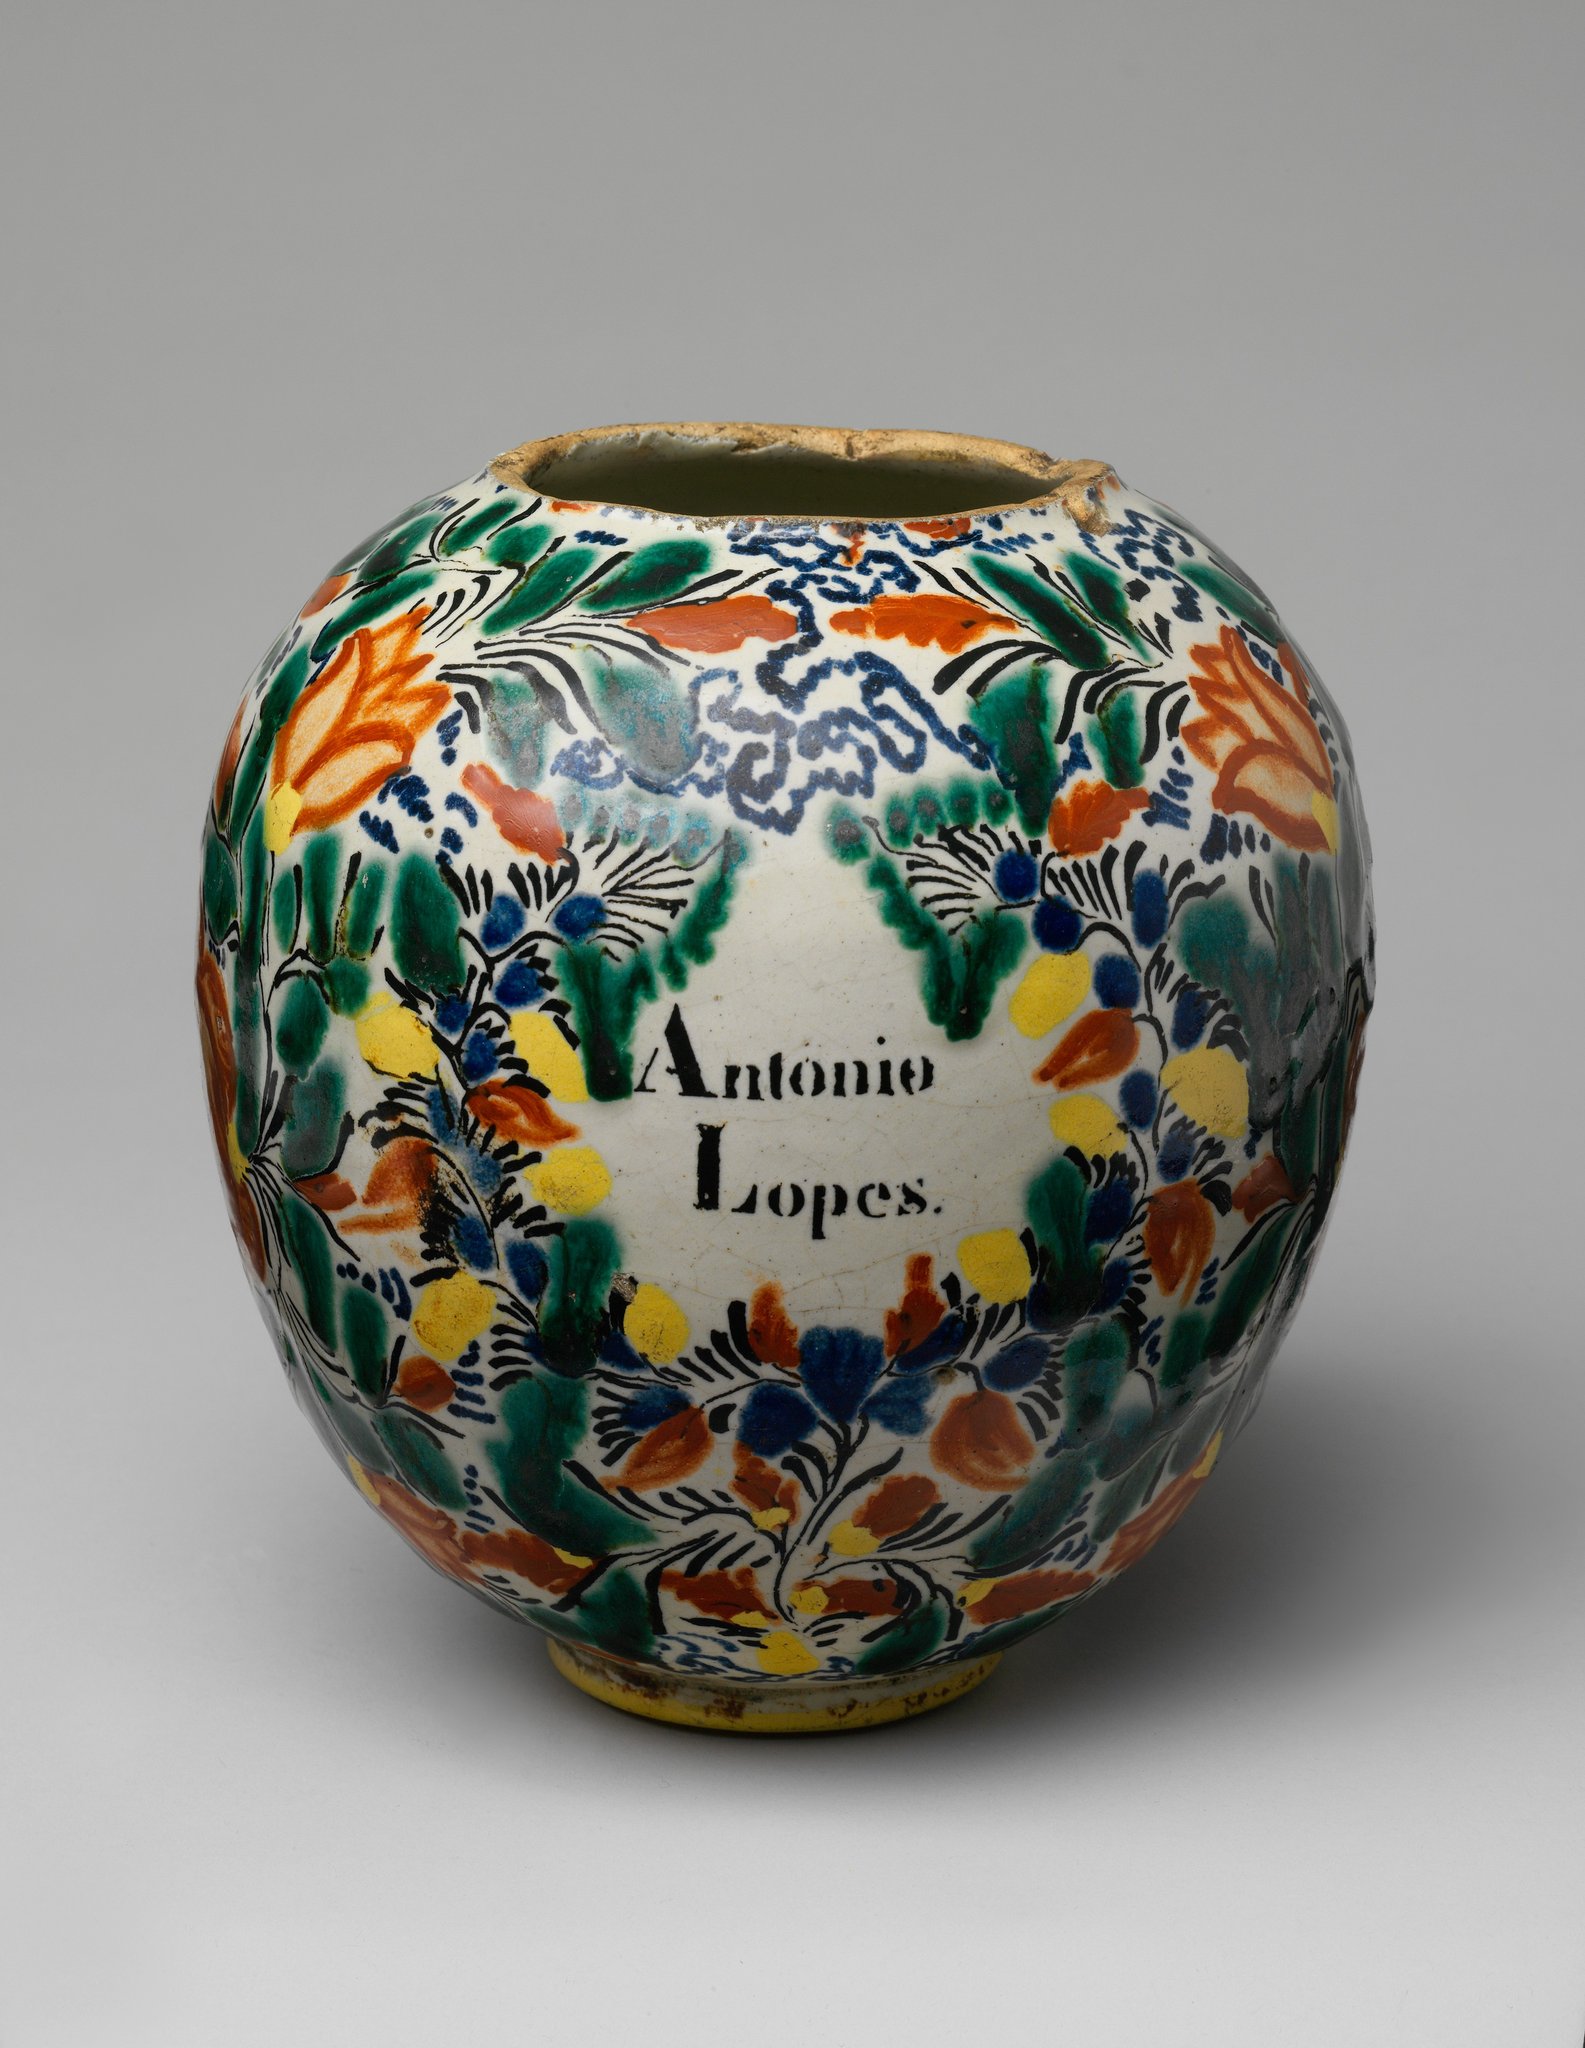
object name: jar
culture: mexican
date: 1860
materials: earthenware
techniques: glazing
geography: mexico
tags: flowers